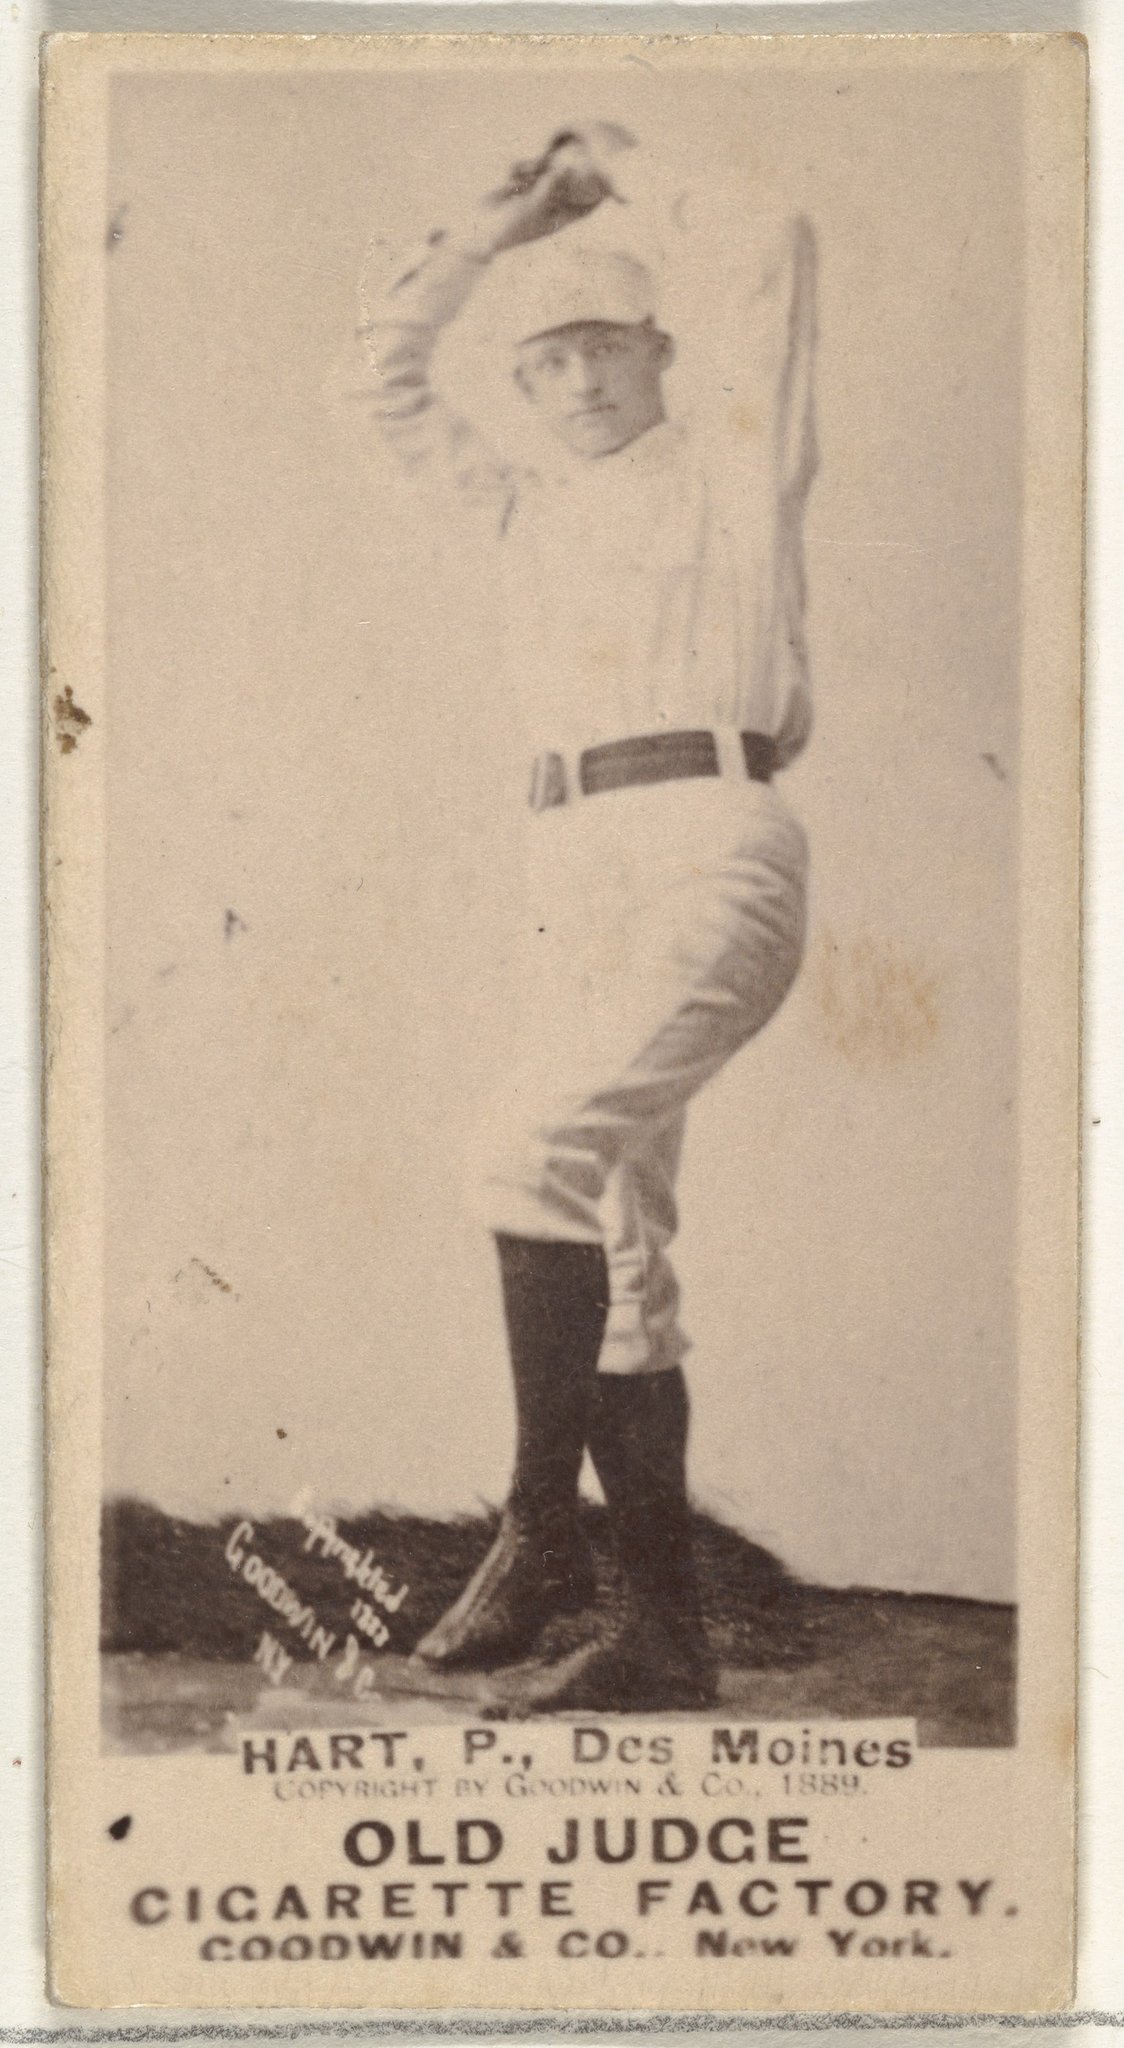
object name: baseball card, photograph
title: William Franklin "Bill" Hart, Pitcher, Des Moines Prohibitionists, from the Old Judge series (N172) for Old Judge Cigarettes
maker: goodwin & company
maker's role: publisher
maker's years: 1850-1950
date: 1889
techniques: albumen silver print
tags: men,portraits,baseball,athletes